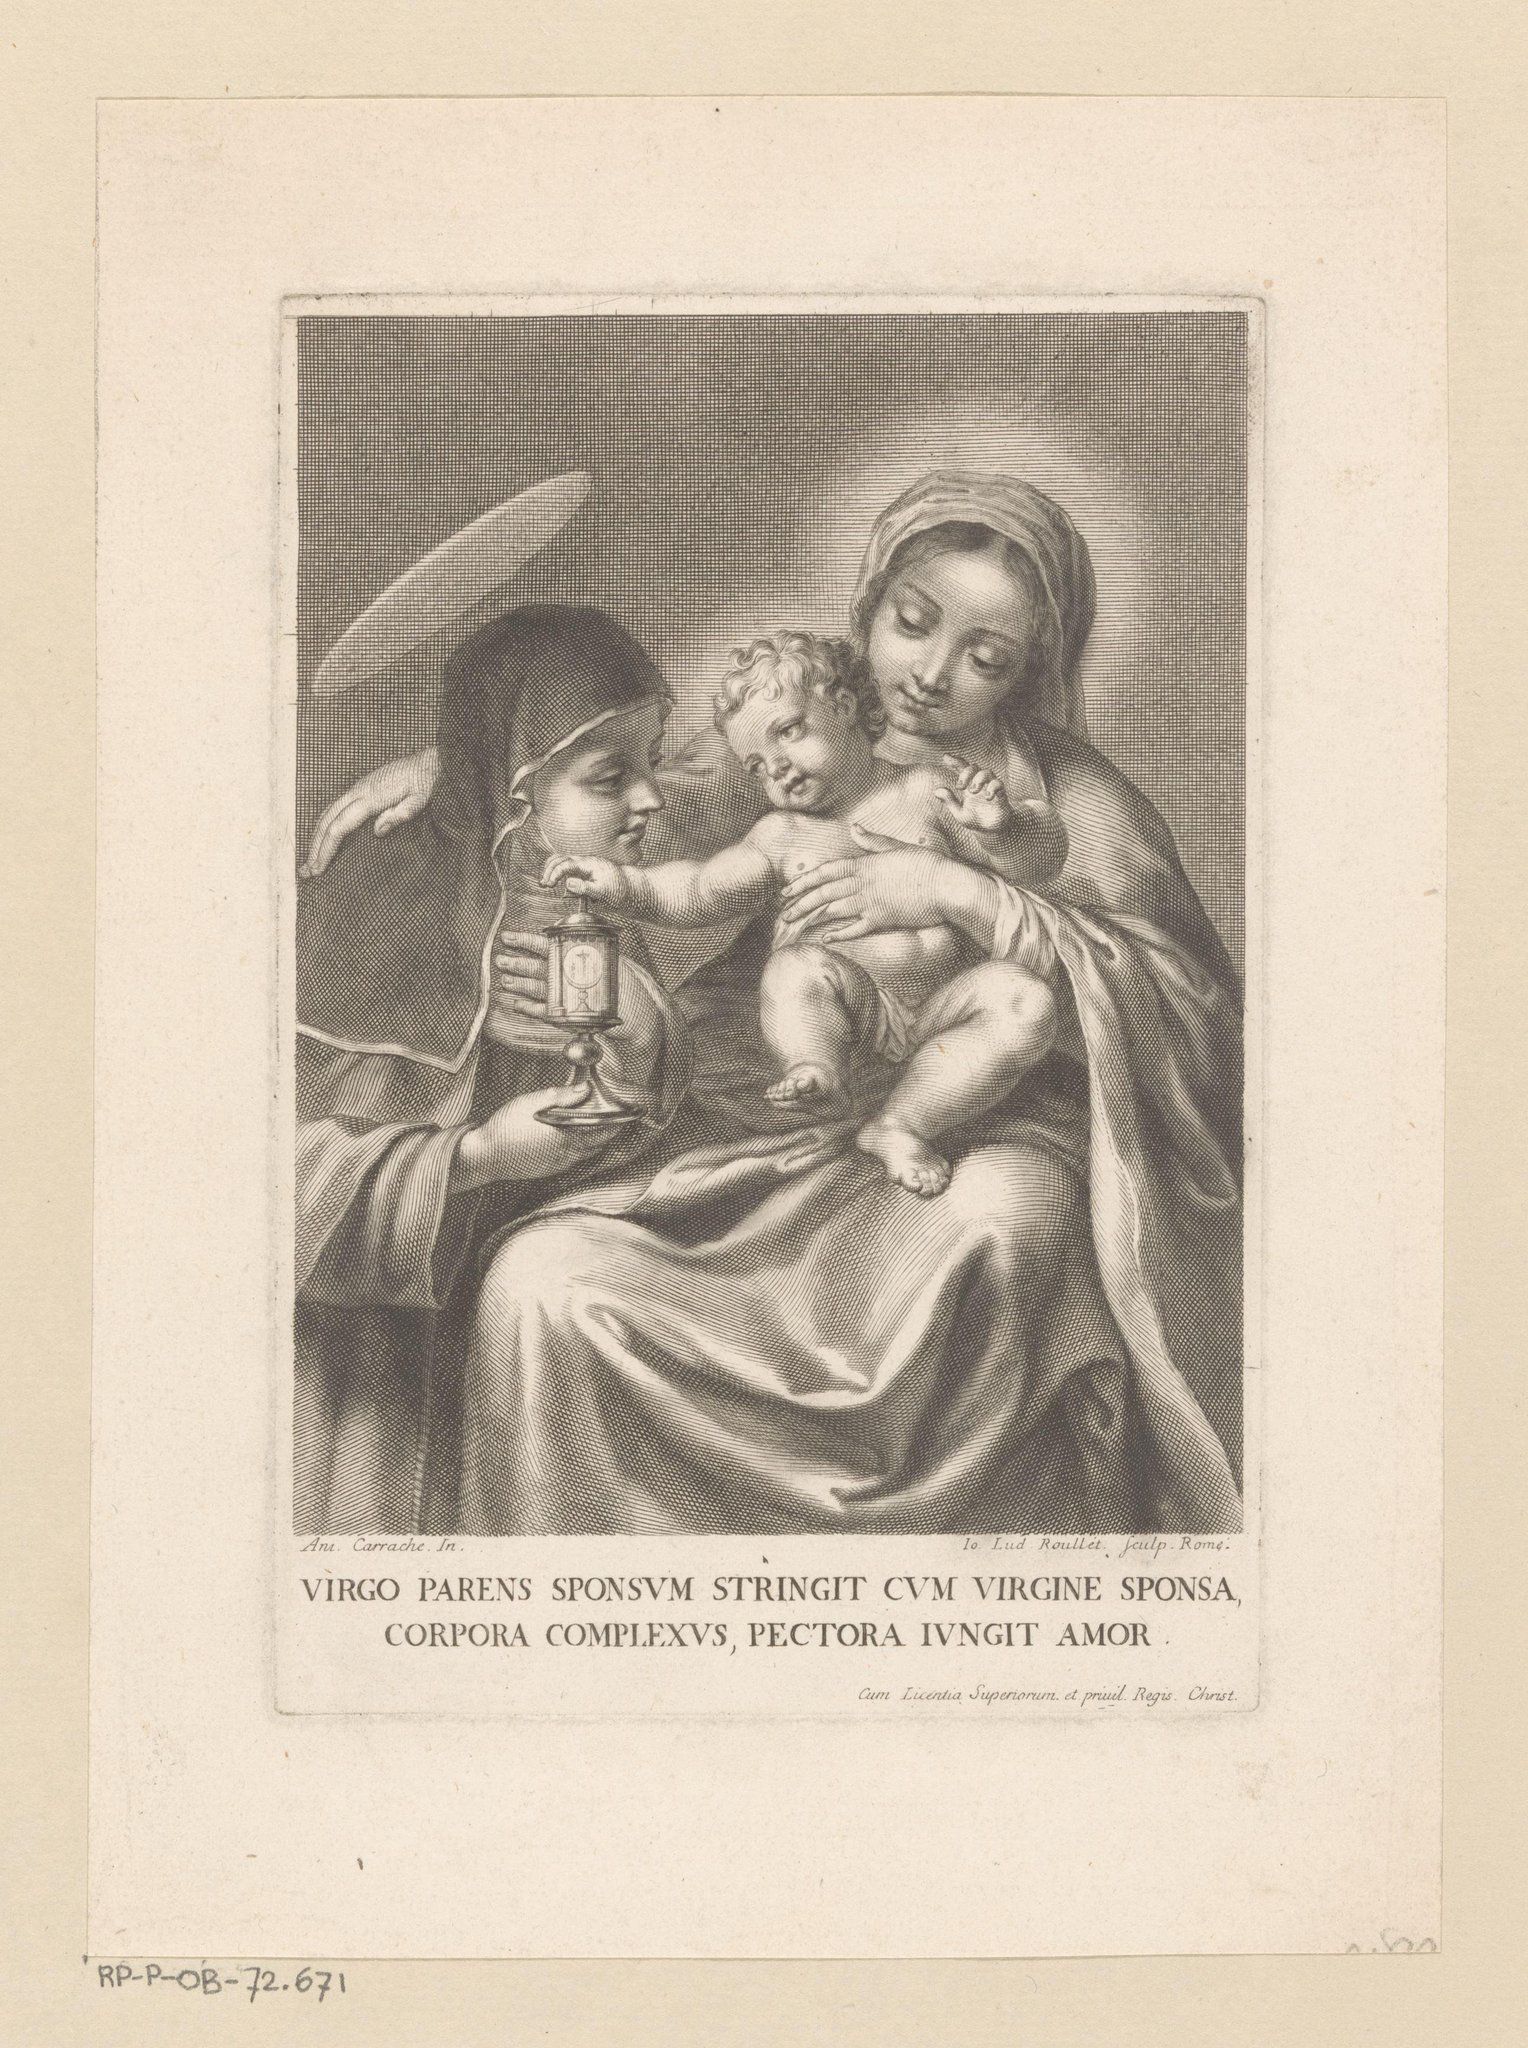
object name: print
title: Maria met kind en vrouwelijke heilige met reliekhouder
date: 1655-1699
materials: paper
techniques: engraving, etching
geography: rome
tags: relics (and reliquaries), madonna: i.e. mary with the christ-child (+ donor(s), supplicant(s), whether or not with patron saint(s))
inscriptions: collector's mark: Lugt 240